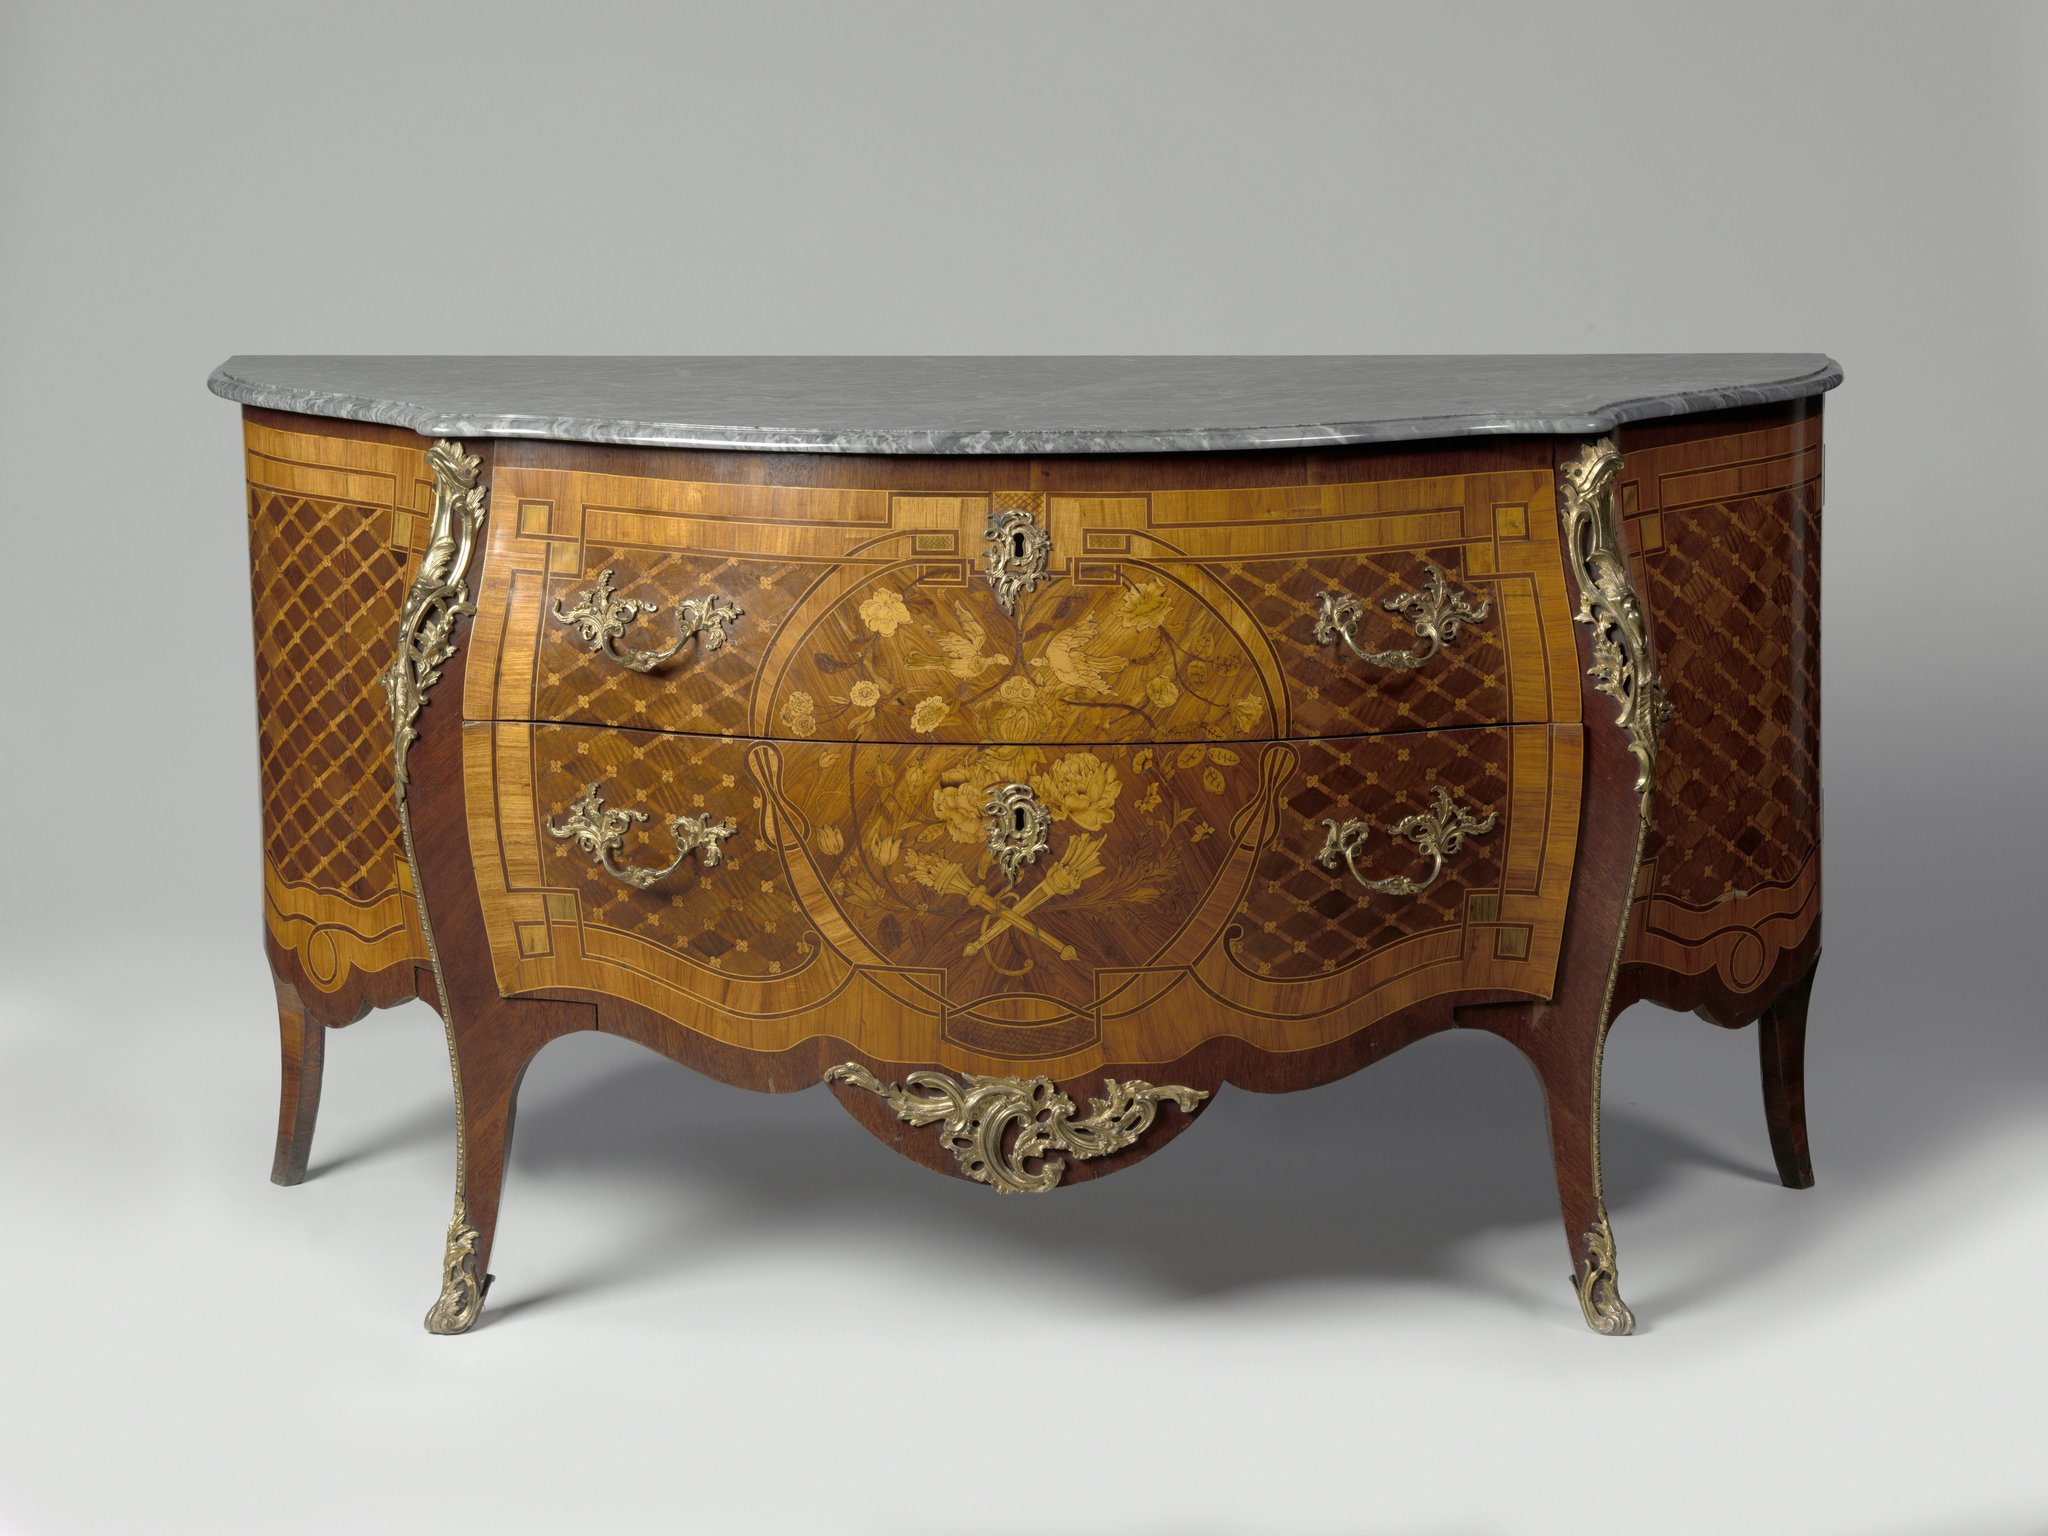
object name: case furniture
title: Commode met twee laden en een deur aan de zijkanten. Marqueterieversiering met ruiten, rozetten en vlechtwerk en midden twee duiven, bloemwerk, boog, toorts en pijlenkoker.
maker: matthijs horrix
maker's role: furniture worker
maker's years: 1735-1809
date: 1765-1770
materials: bronze, wood, marble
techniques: gilding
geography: the hague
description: Commode. Oak, veneered with tulipwood, sycamore, mahogany and other woods. The Hague, c. 1765 - 1770, probably circle of Matthijs Horrix.